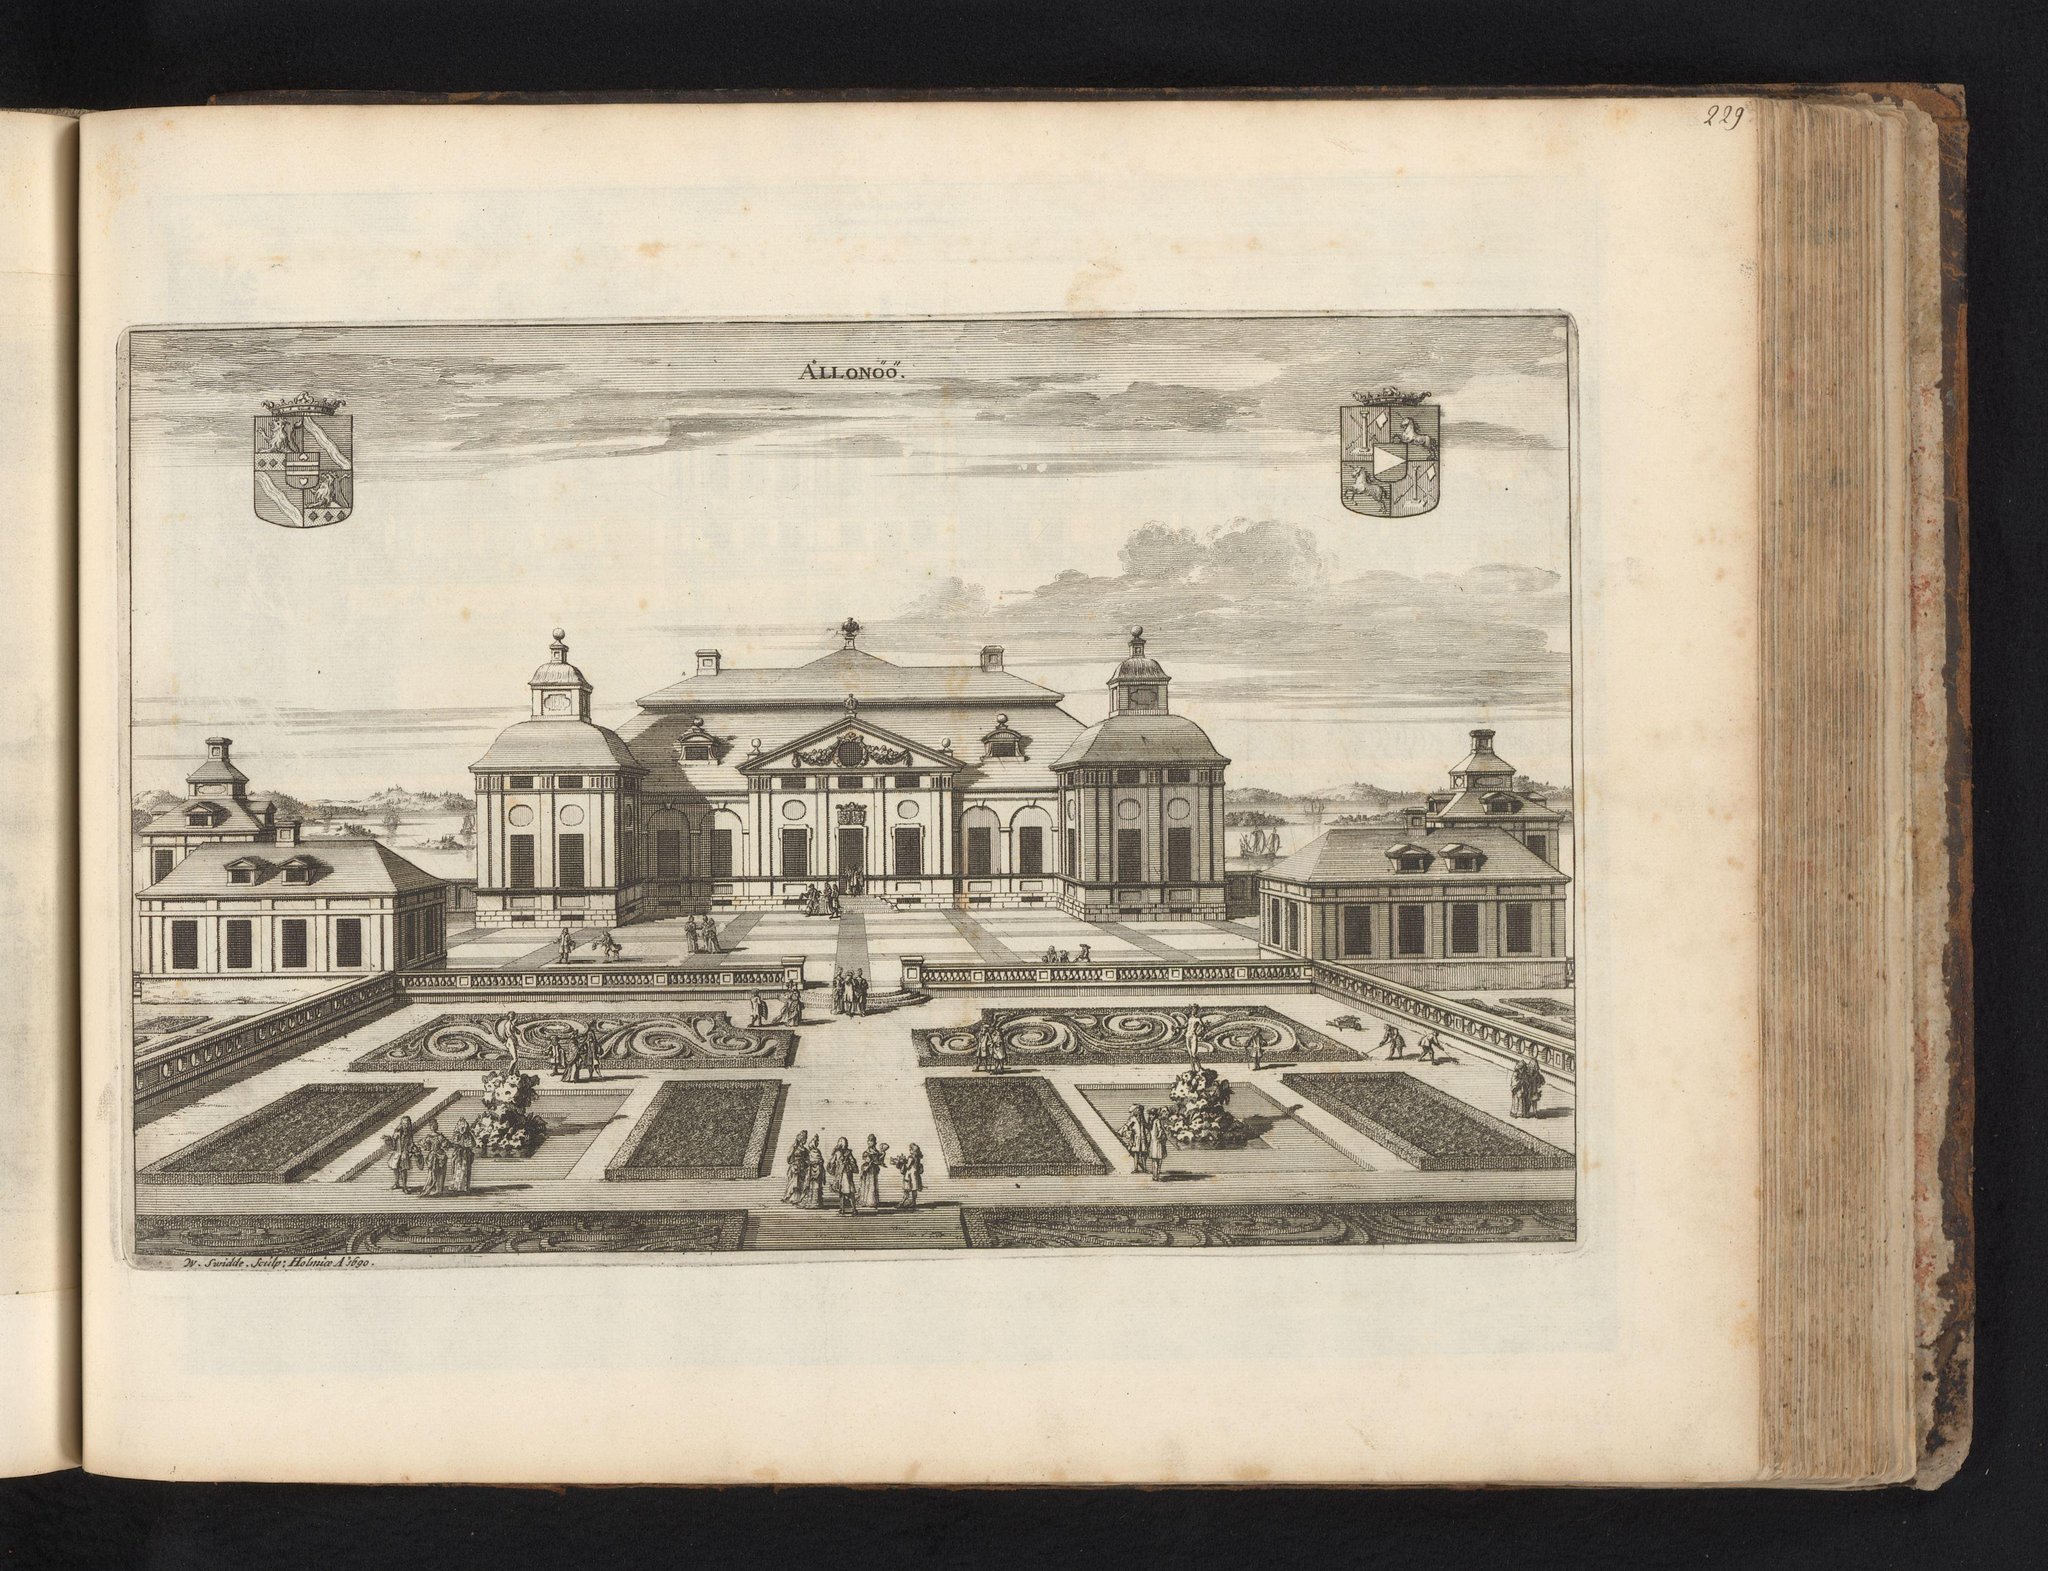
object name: album leaf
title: Gezicht op slot Ållonö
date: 1690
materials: paper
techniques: etching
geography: stockholm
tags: housing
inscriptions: date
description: Kungliga Biblioteket, 'Suecia': http://www.kb.se/samlingarna/Kartor-bilder/Suecia-antiqua/ (geraadpleegd november 2016).